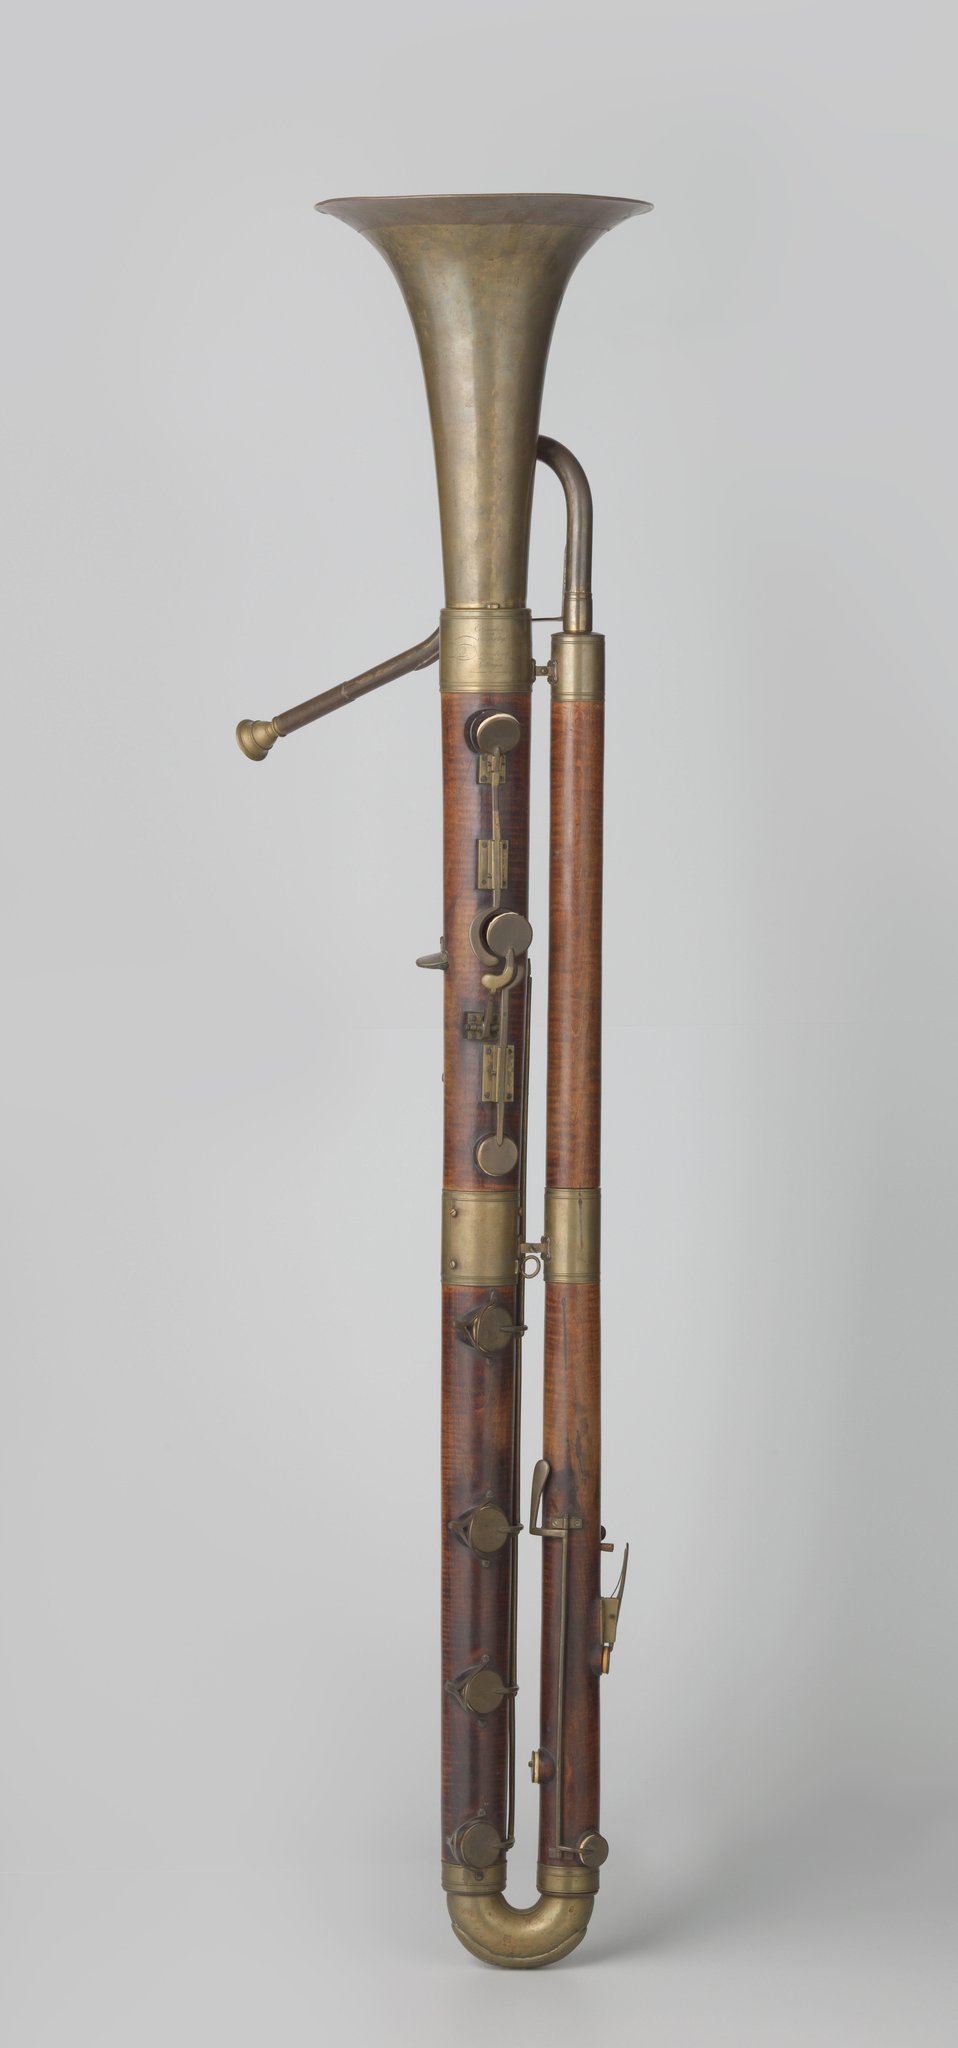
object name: serpent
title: Bass Horn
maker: johann heinrich gottlieb streitwolf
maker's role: musical instrument maker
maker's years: 1779-1837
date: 1820-1830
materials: copper, wood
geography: gottingen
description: Music has always been a crucial element of public celebrations, such as military parades, coronations, royal weddings, and funerals, adding grandeur to the solemnity of the occasion. Musical ensembles entrusted with performing music at these events have existed in Europe since the Middle Ages. This display highlights various marching bands and their musical instruments dating from the 16th to the 19th century.